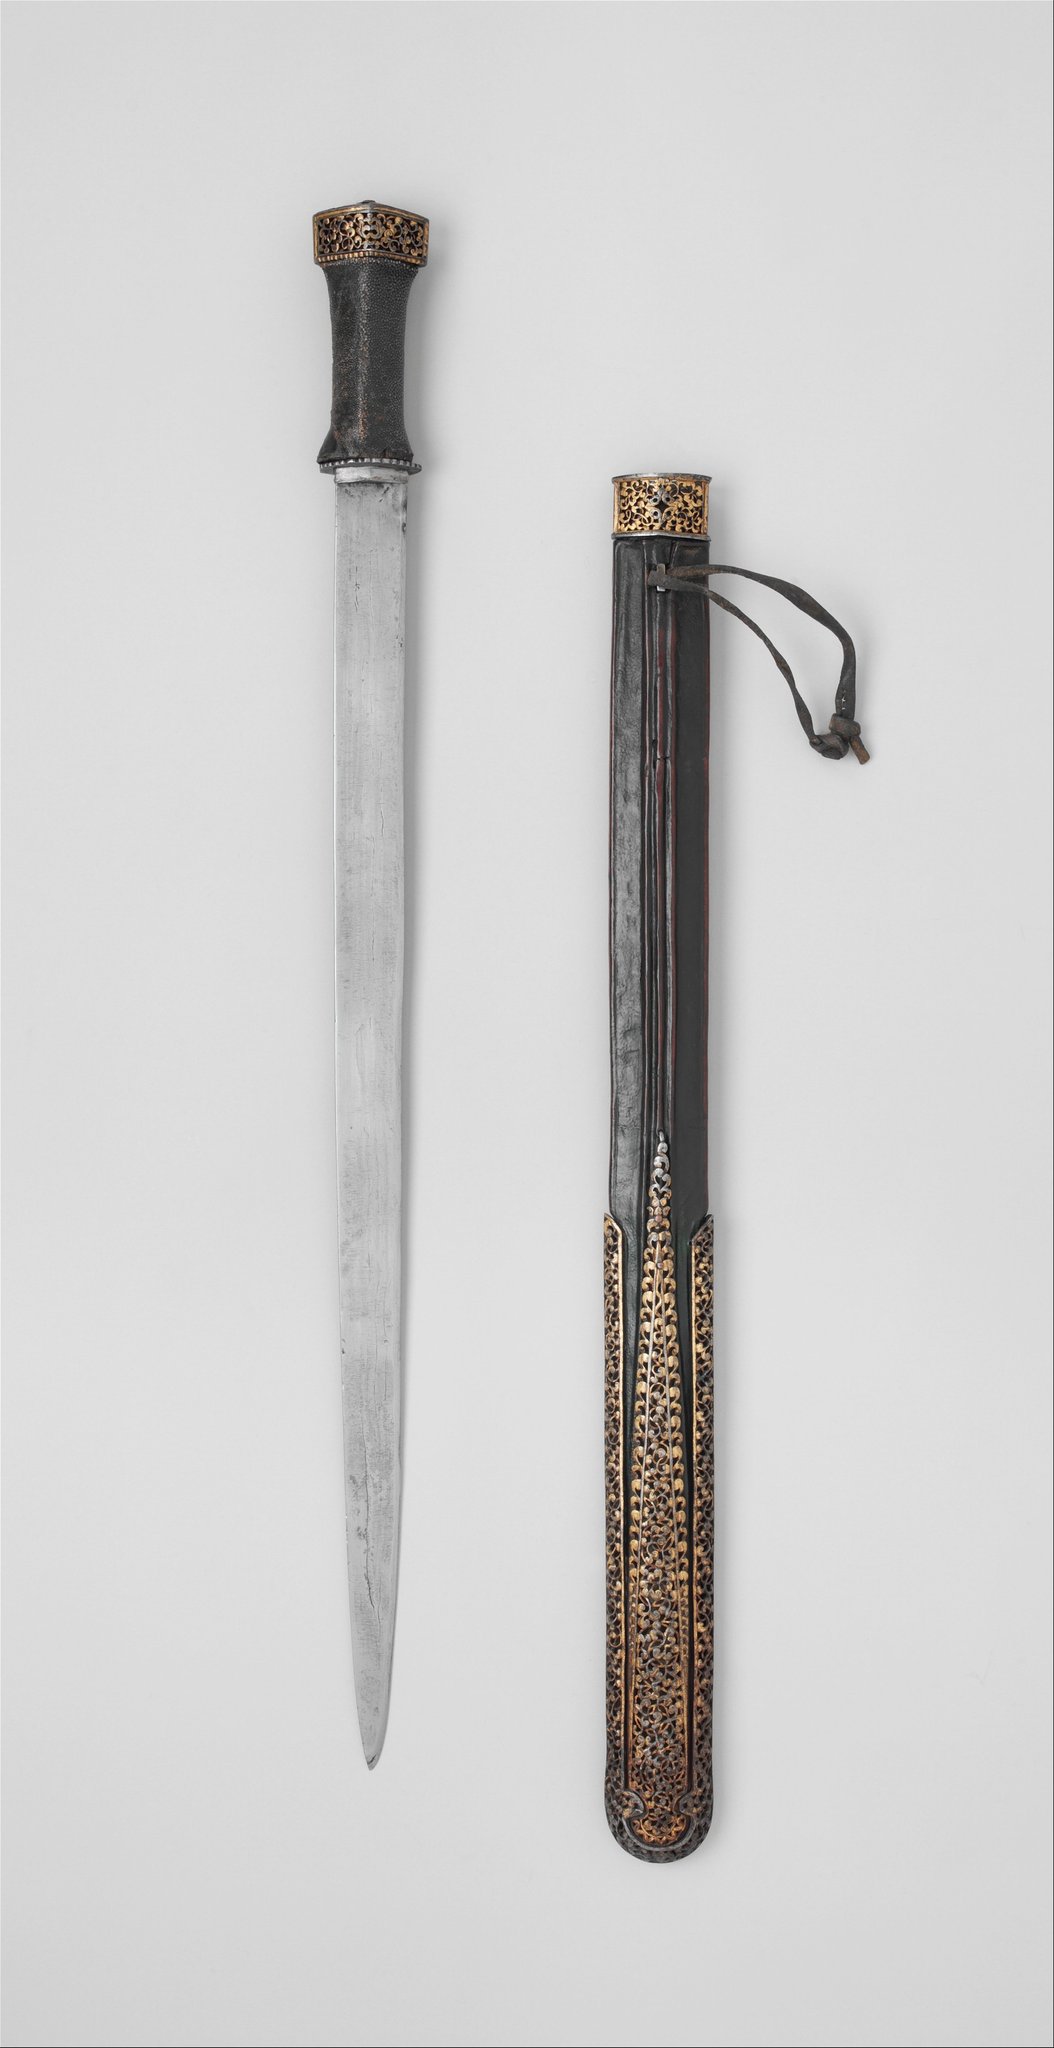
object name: sword with scabbard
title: Sword and Scabbard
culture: southern or eastern tibetan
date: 1501-1800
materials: gold, iron, leather, silver, skin, wood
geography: tibet